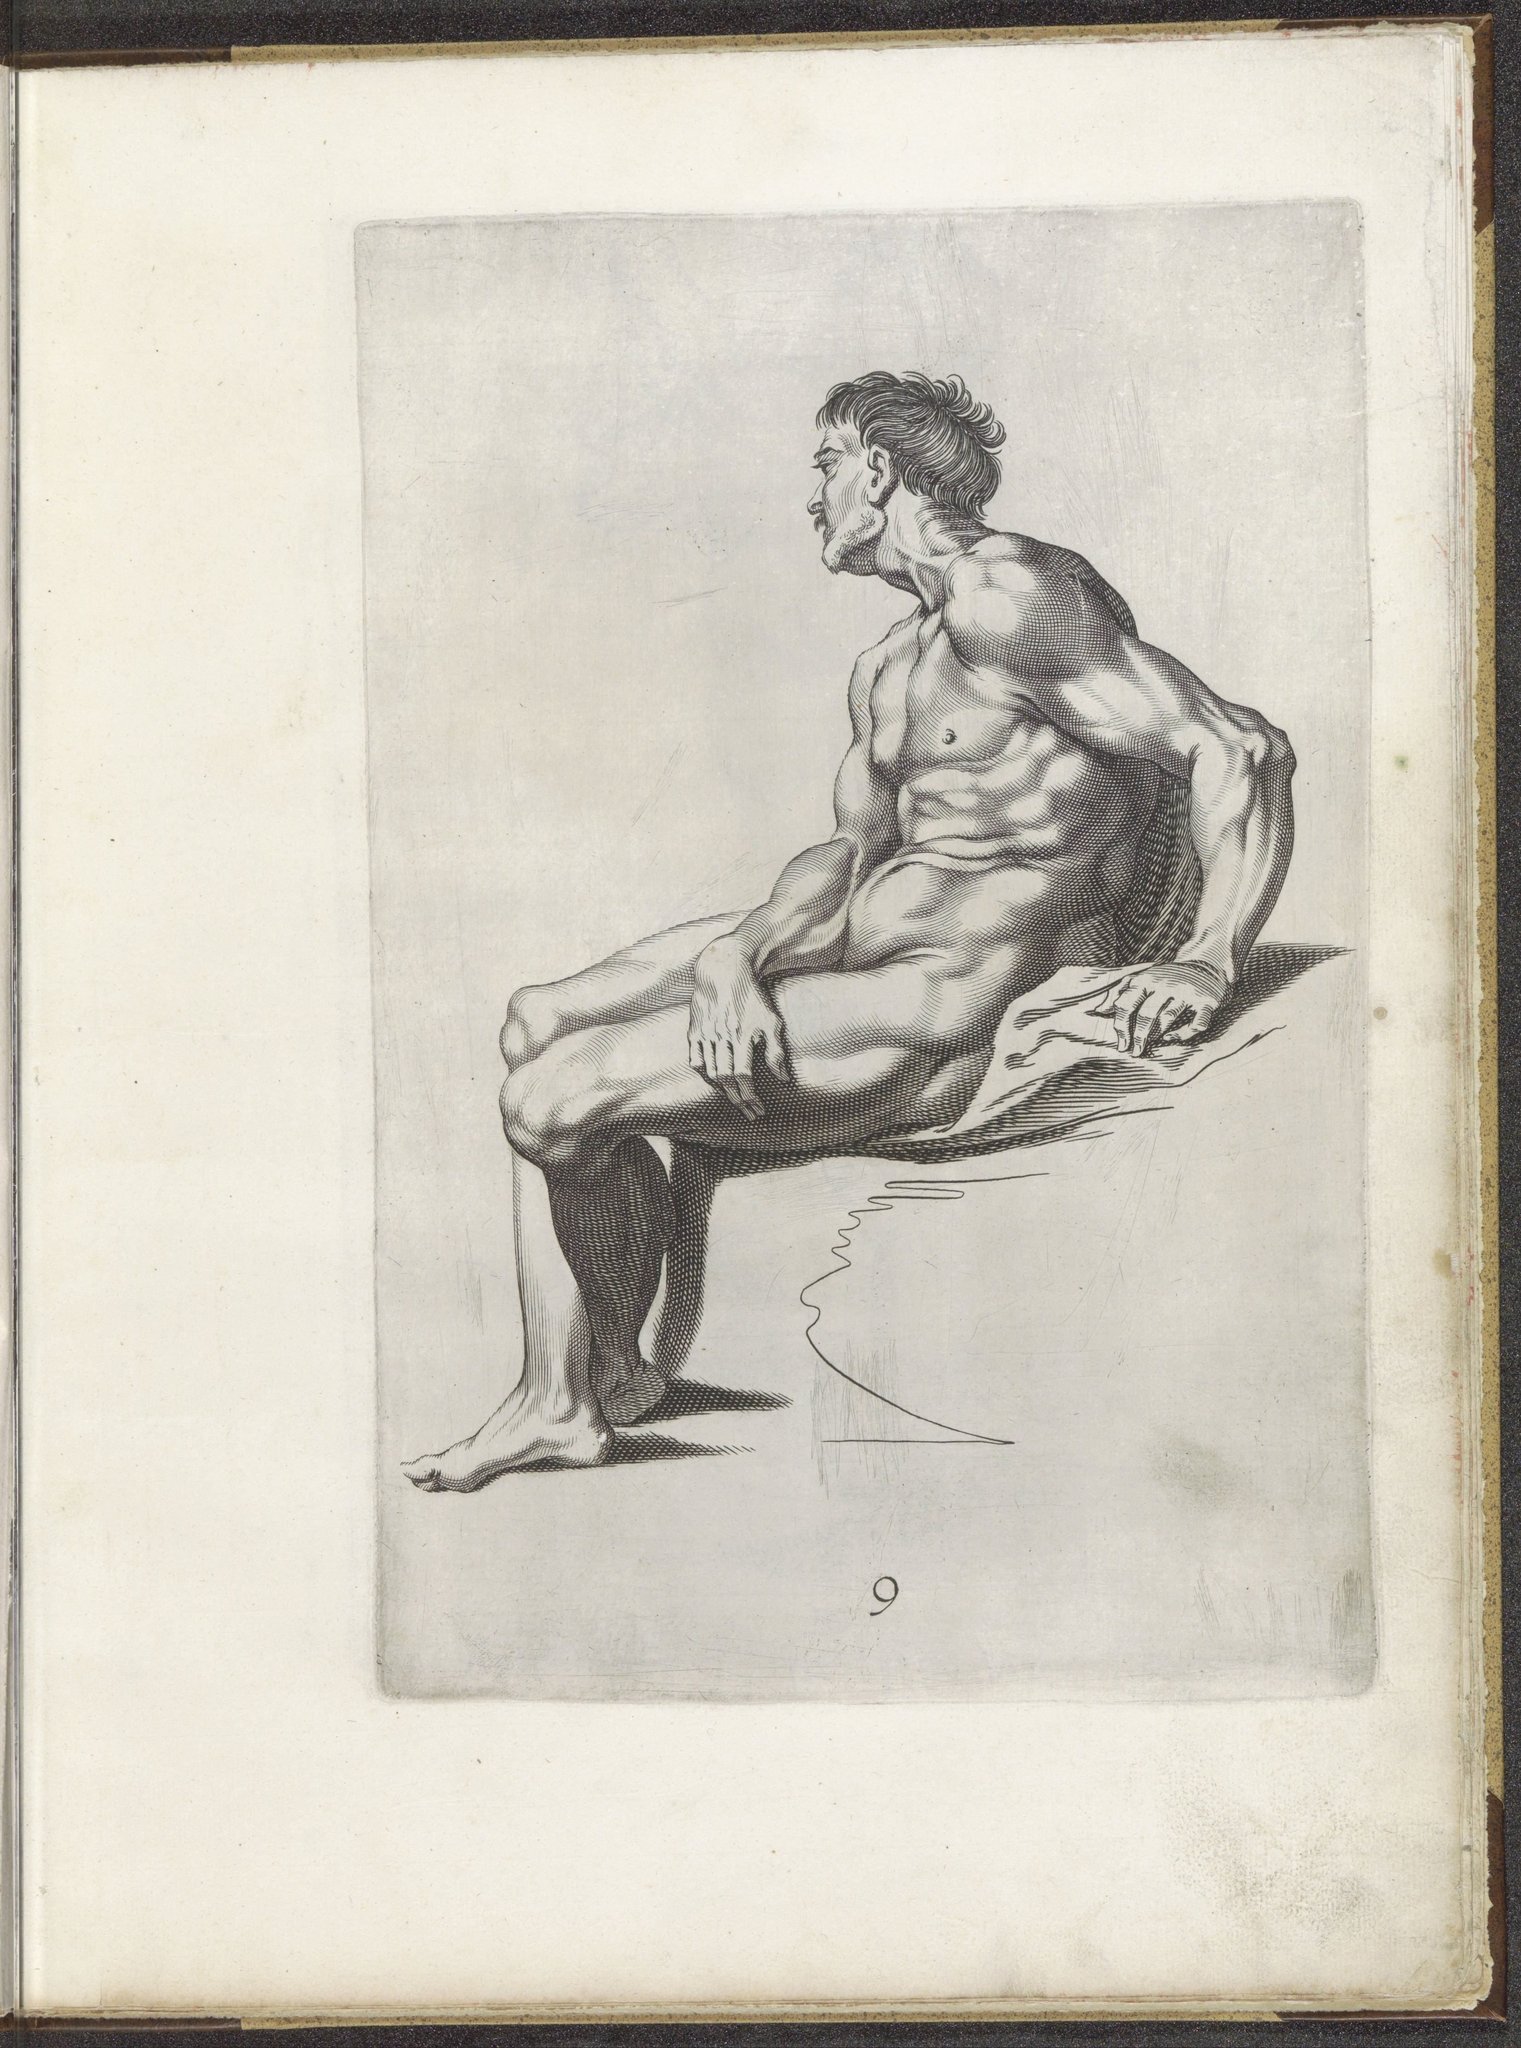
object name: print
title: Varie figvre academiche / Diversche figvren wt de academia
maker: pieter de jode (i)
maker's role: draughtsman, print maker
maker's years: 1570-1634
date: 1629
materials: paper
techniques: engraving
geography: antwerp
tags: sitting figure, human figure of ideal proportions, e.g. academic nude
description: Tekenvoorbeeld van een zittend mannelijk naakt naar links. Deze prent maakt deel uit van een album.